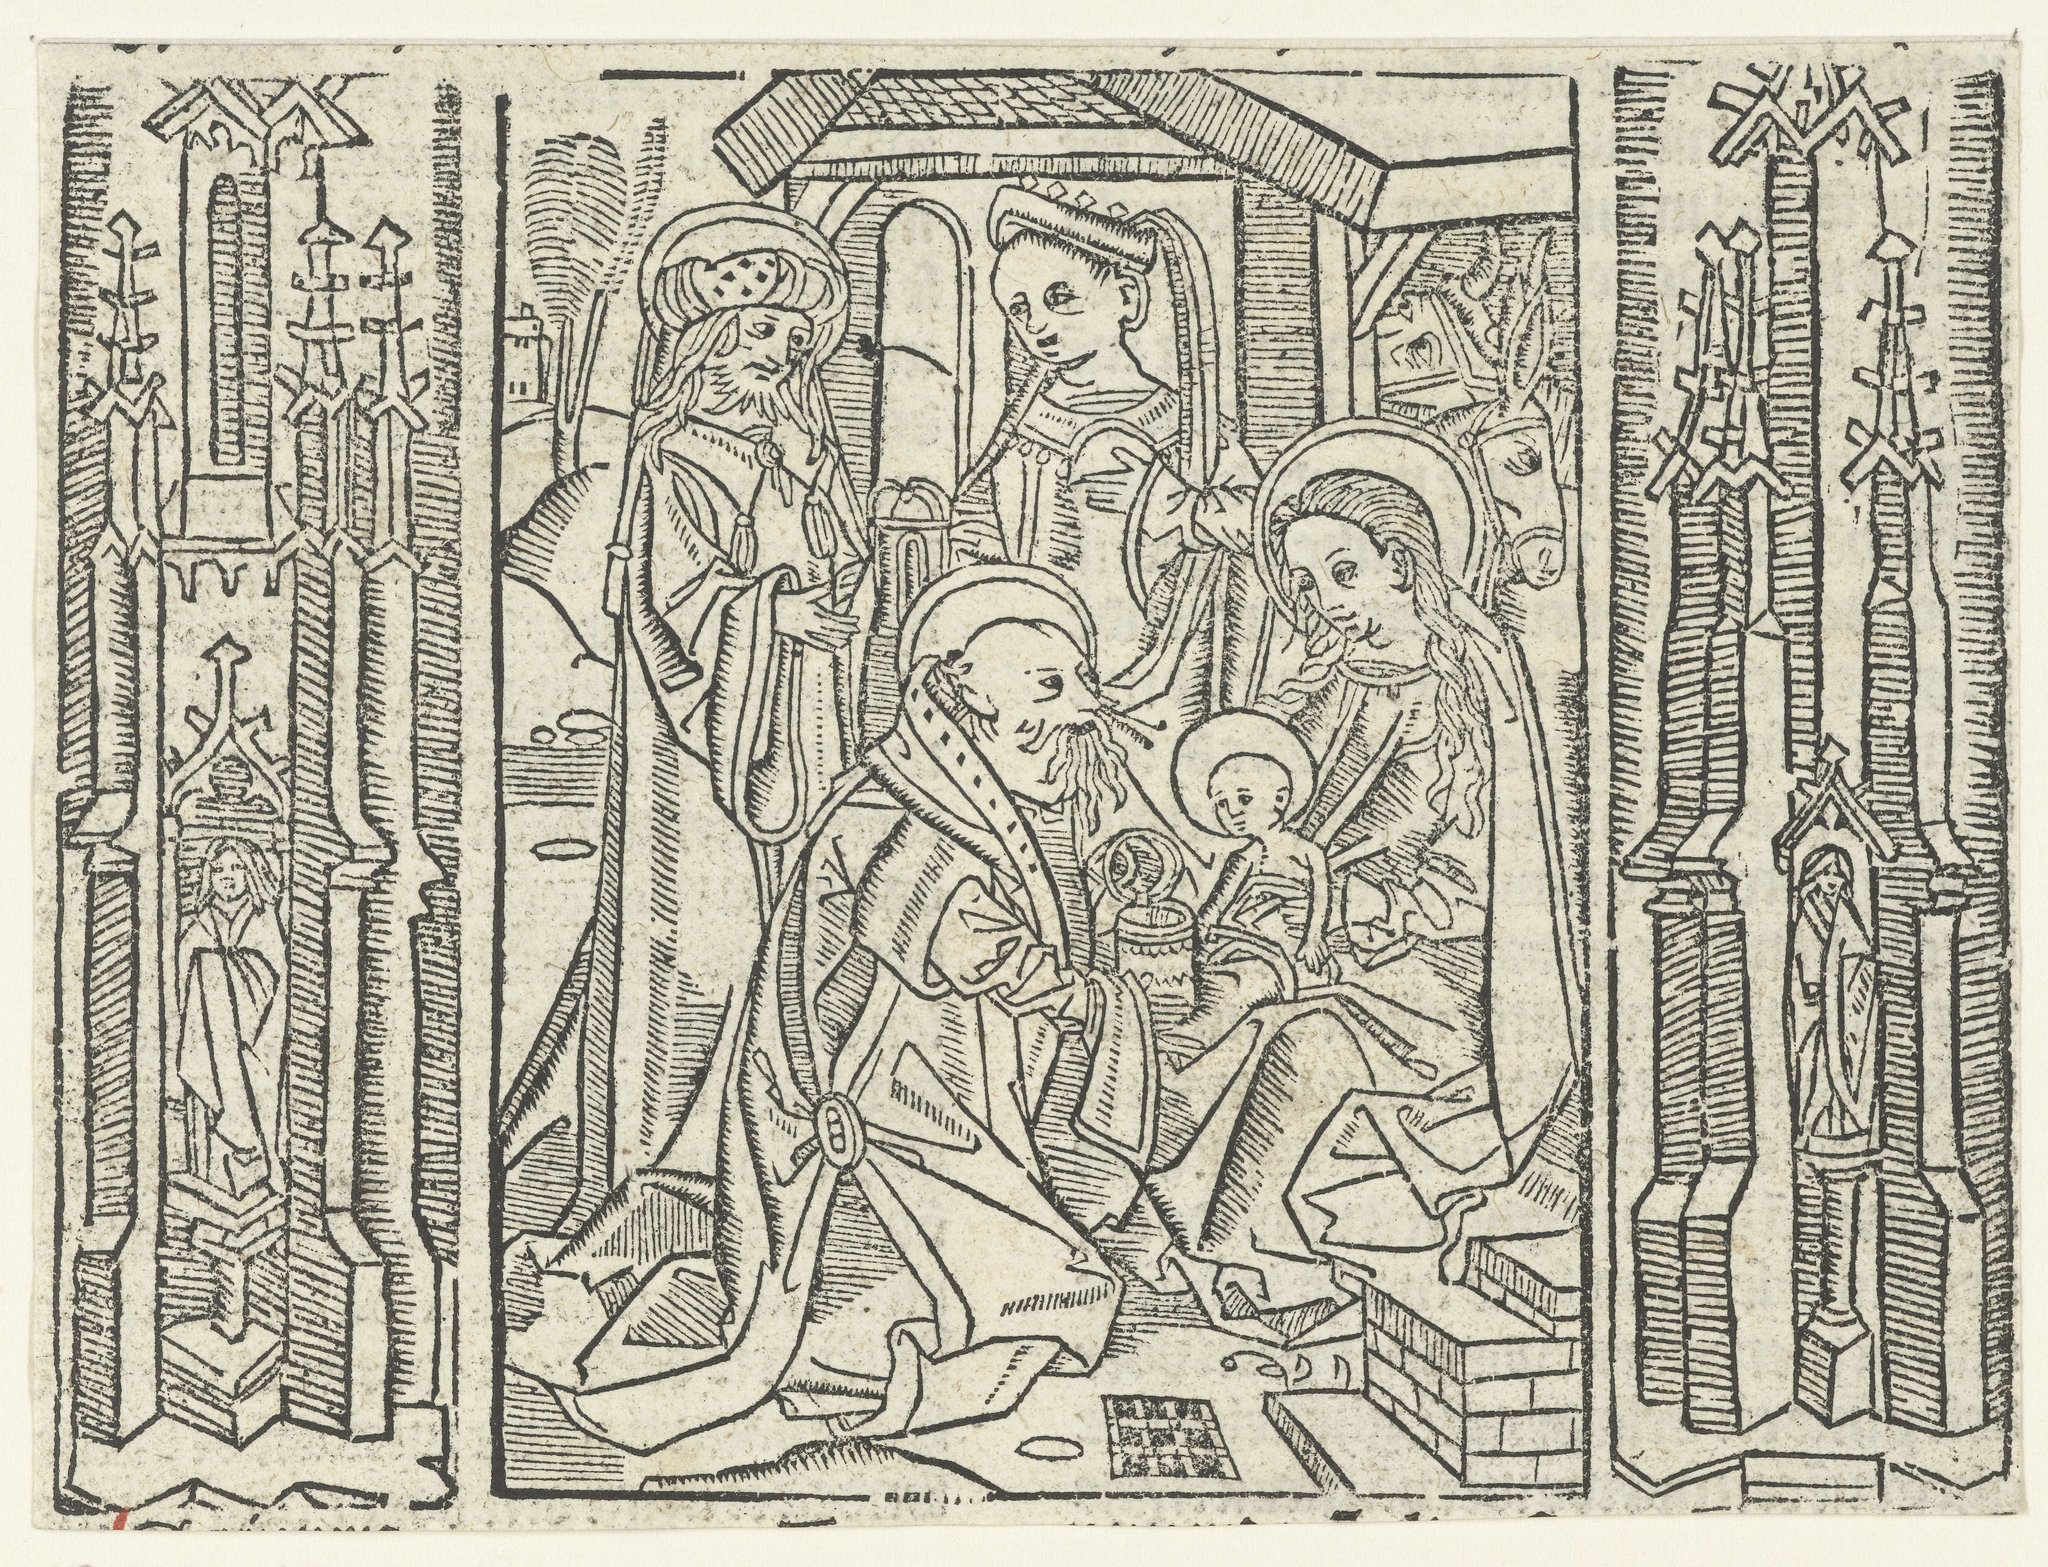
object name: print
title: Aanbidding der koningen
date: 1480-1500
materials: paper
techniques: woodcut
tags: adoration of the kings: the wise men present their gifts to the christ-child (gold, frankincense and myrrh)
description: Eén blad van 113 uit Ludolphus de Saxonia, "Dit es dleué ons liefs heeren ihesu christi". Anonieme Nederlandse vertaling. Uitgegeven door Henrick Eckert van Homberch te Antwerpen in 1503. Botke, K. Deze 113 houtsneden, die meestal reeds in vroege Nederlandse boeken gebruikt zijn, worden toegeschreven aan de tweede Meester van Delft, de Meester van de Delbecq-Schreiber-passie en de Meester van de Virgo inter Virgines. In Conway (1884) en in "De gulden passer"(1951) zijn ook eerdere versies opgenomen. Botke, K.